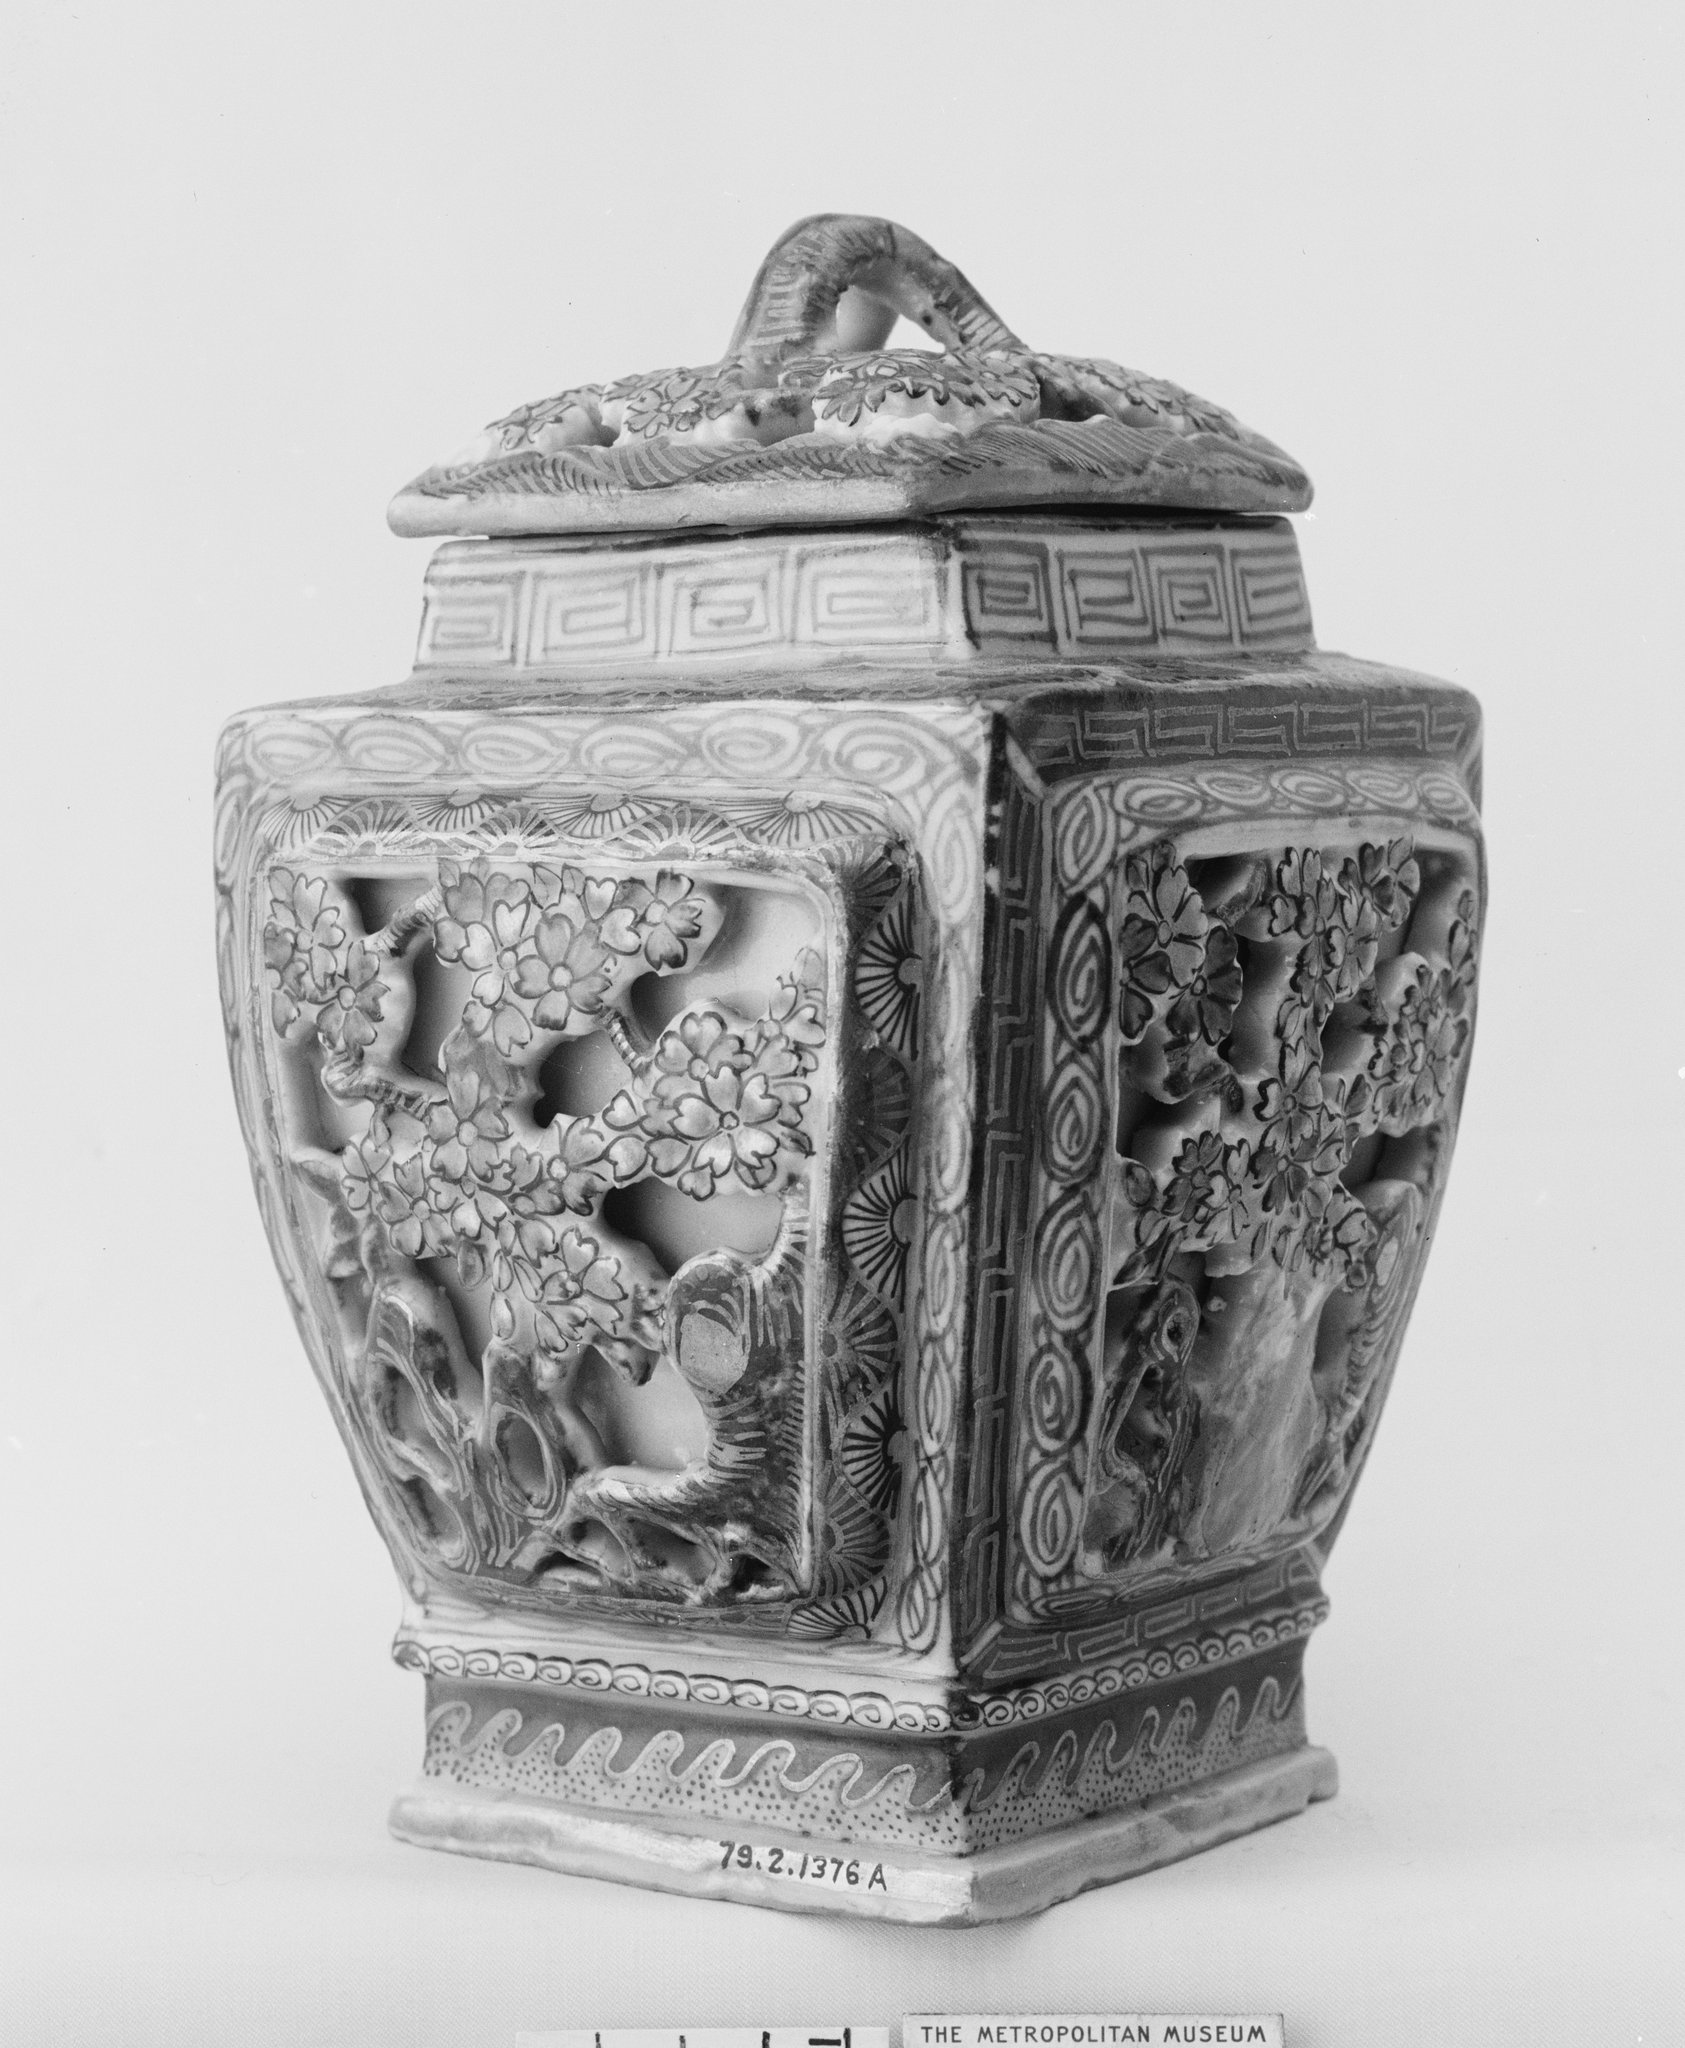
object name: jar with cover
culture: japanese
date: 1701-1800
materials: enamel, glaze, porcelain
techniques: polychrome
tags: flowers